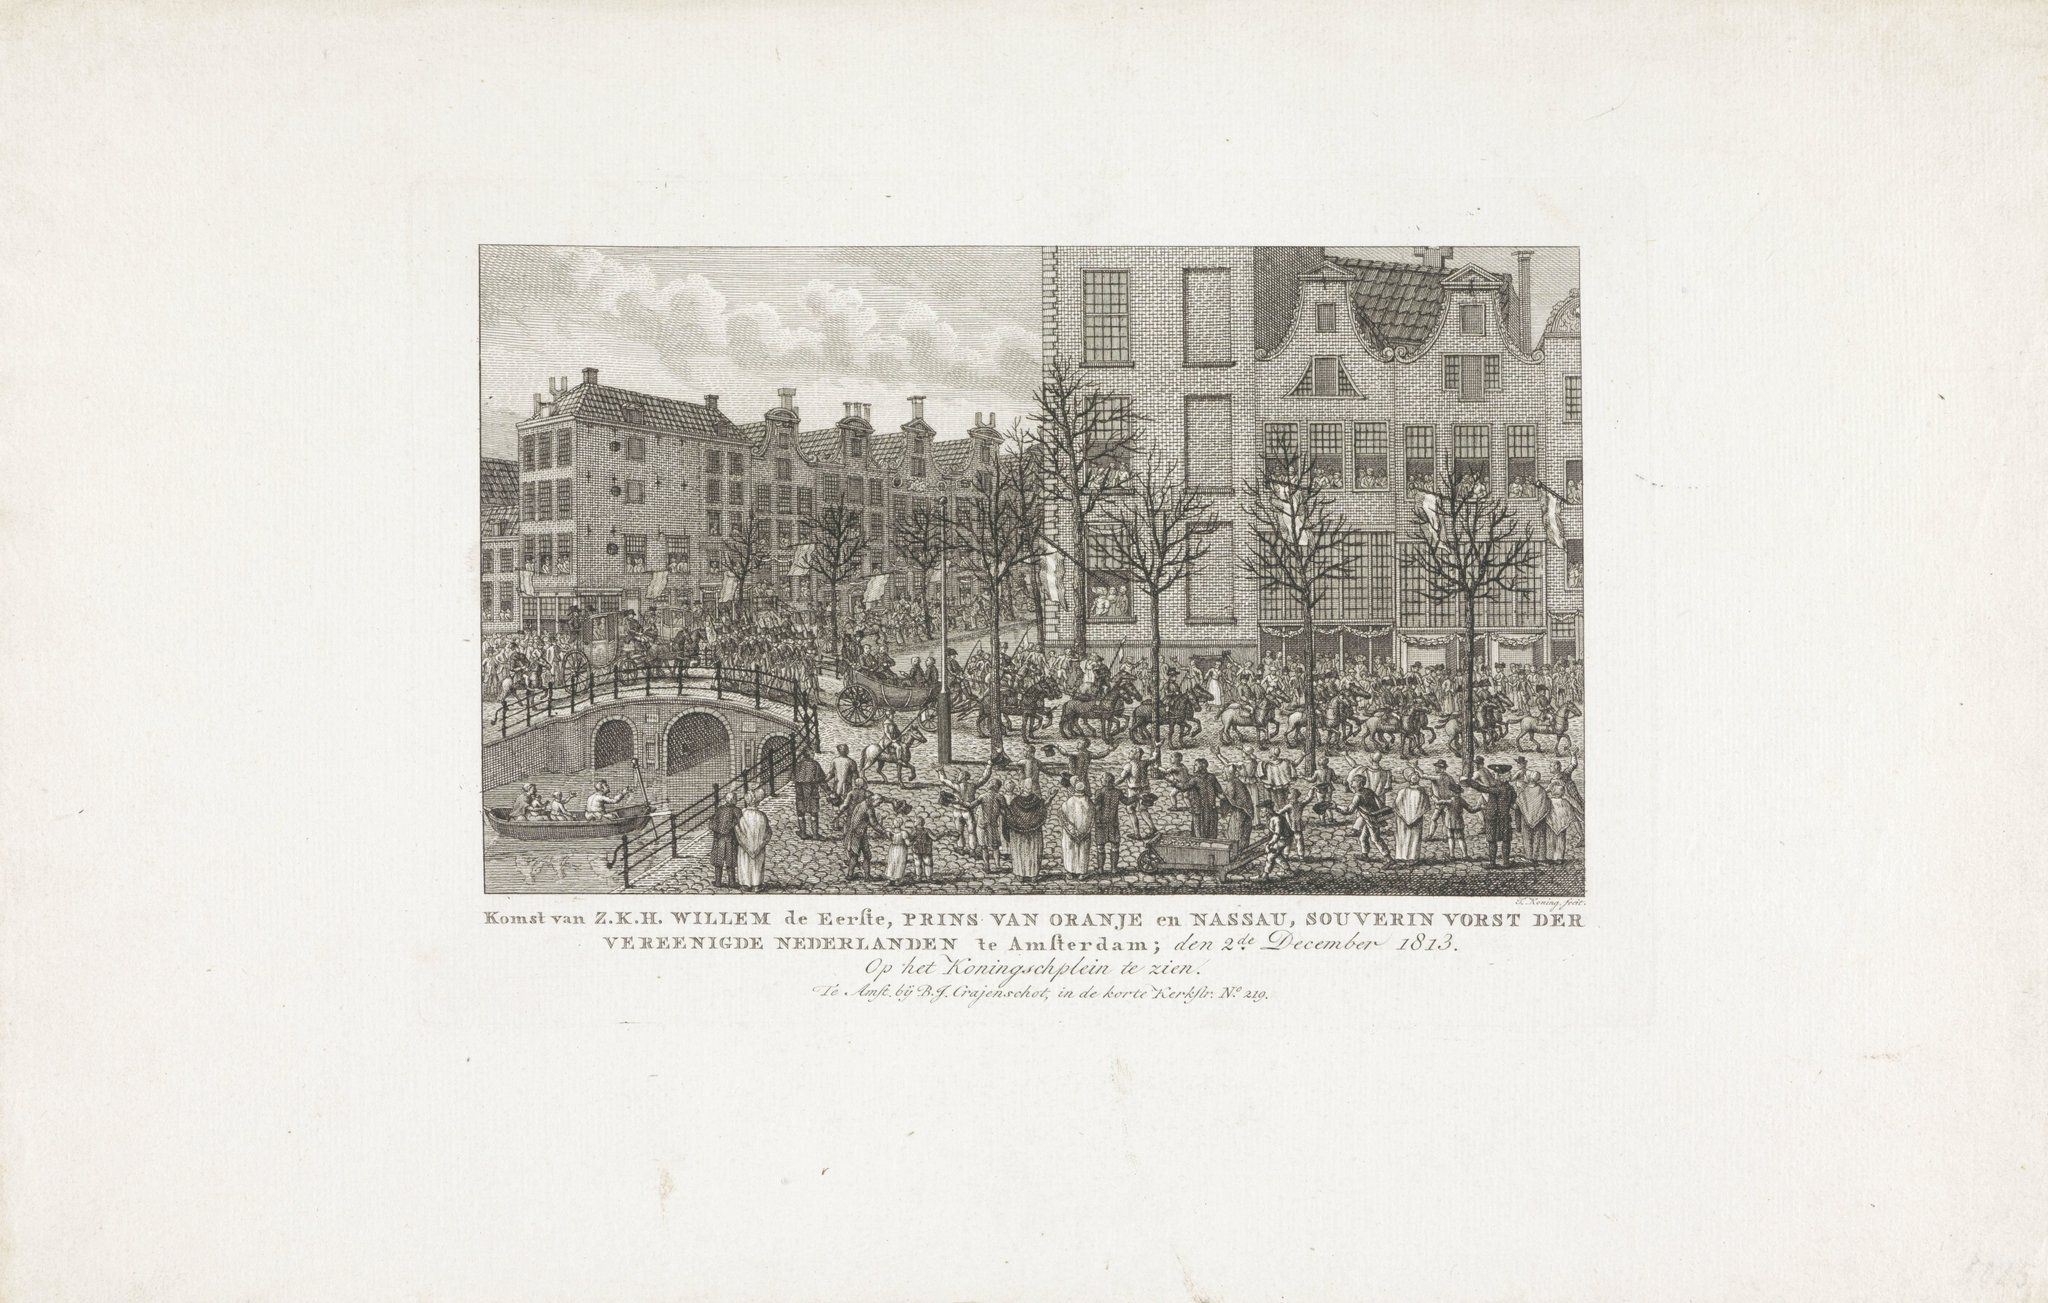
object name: print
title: Intocht van prins Willem Frederik te Amsterdam, 1813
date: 1813-1814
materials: paper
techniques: engraving, etching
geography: amsterdam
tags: the hague, berlin, william i of the netherlands, public festivities at other royal events, not meant or mentioned above, triumphal entry and public reception, pageant, 'entrée solennelle', 'joyeuse entrée', amsterdam, landing of william frederick i (1813)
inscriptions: collector's mark: Lugt 2228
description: Intocht van prins Willem Frederik als Souverein Vorst te Amsterdam op 2 december 1813. Stoet met rijtug met de prins komt uit de Leidsestraat aan op het Koningsplein. Langs de kanten van weg juichende toeschouwers.